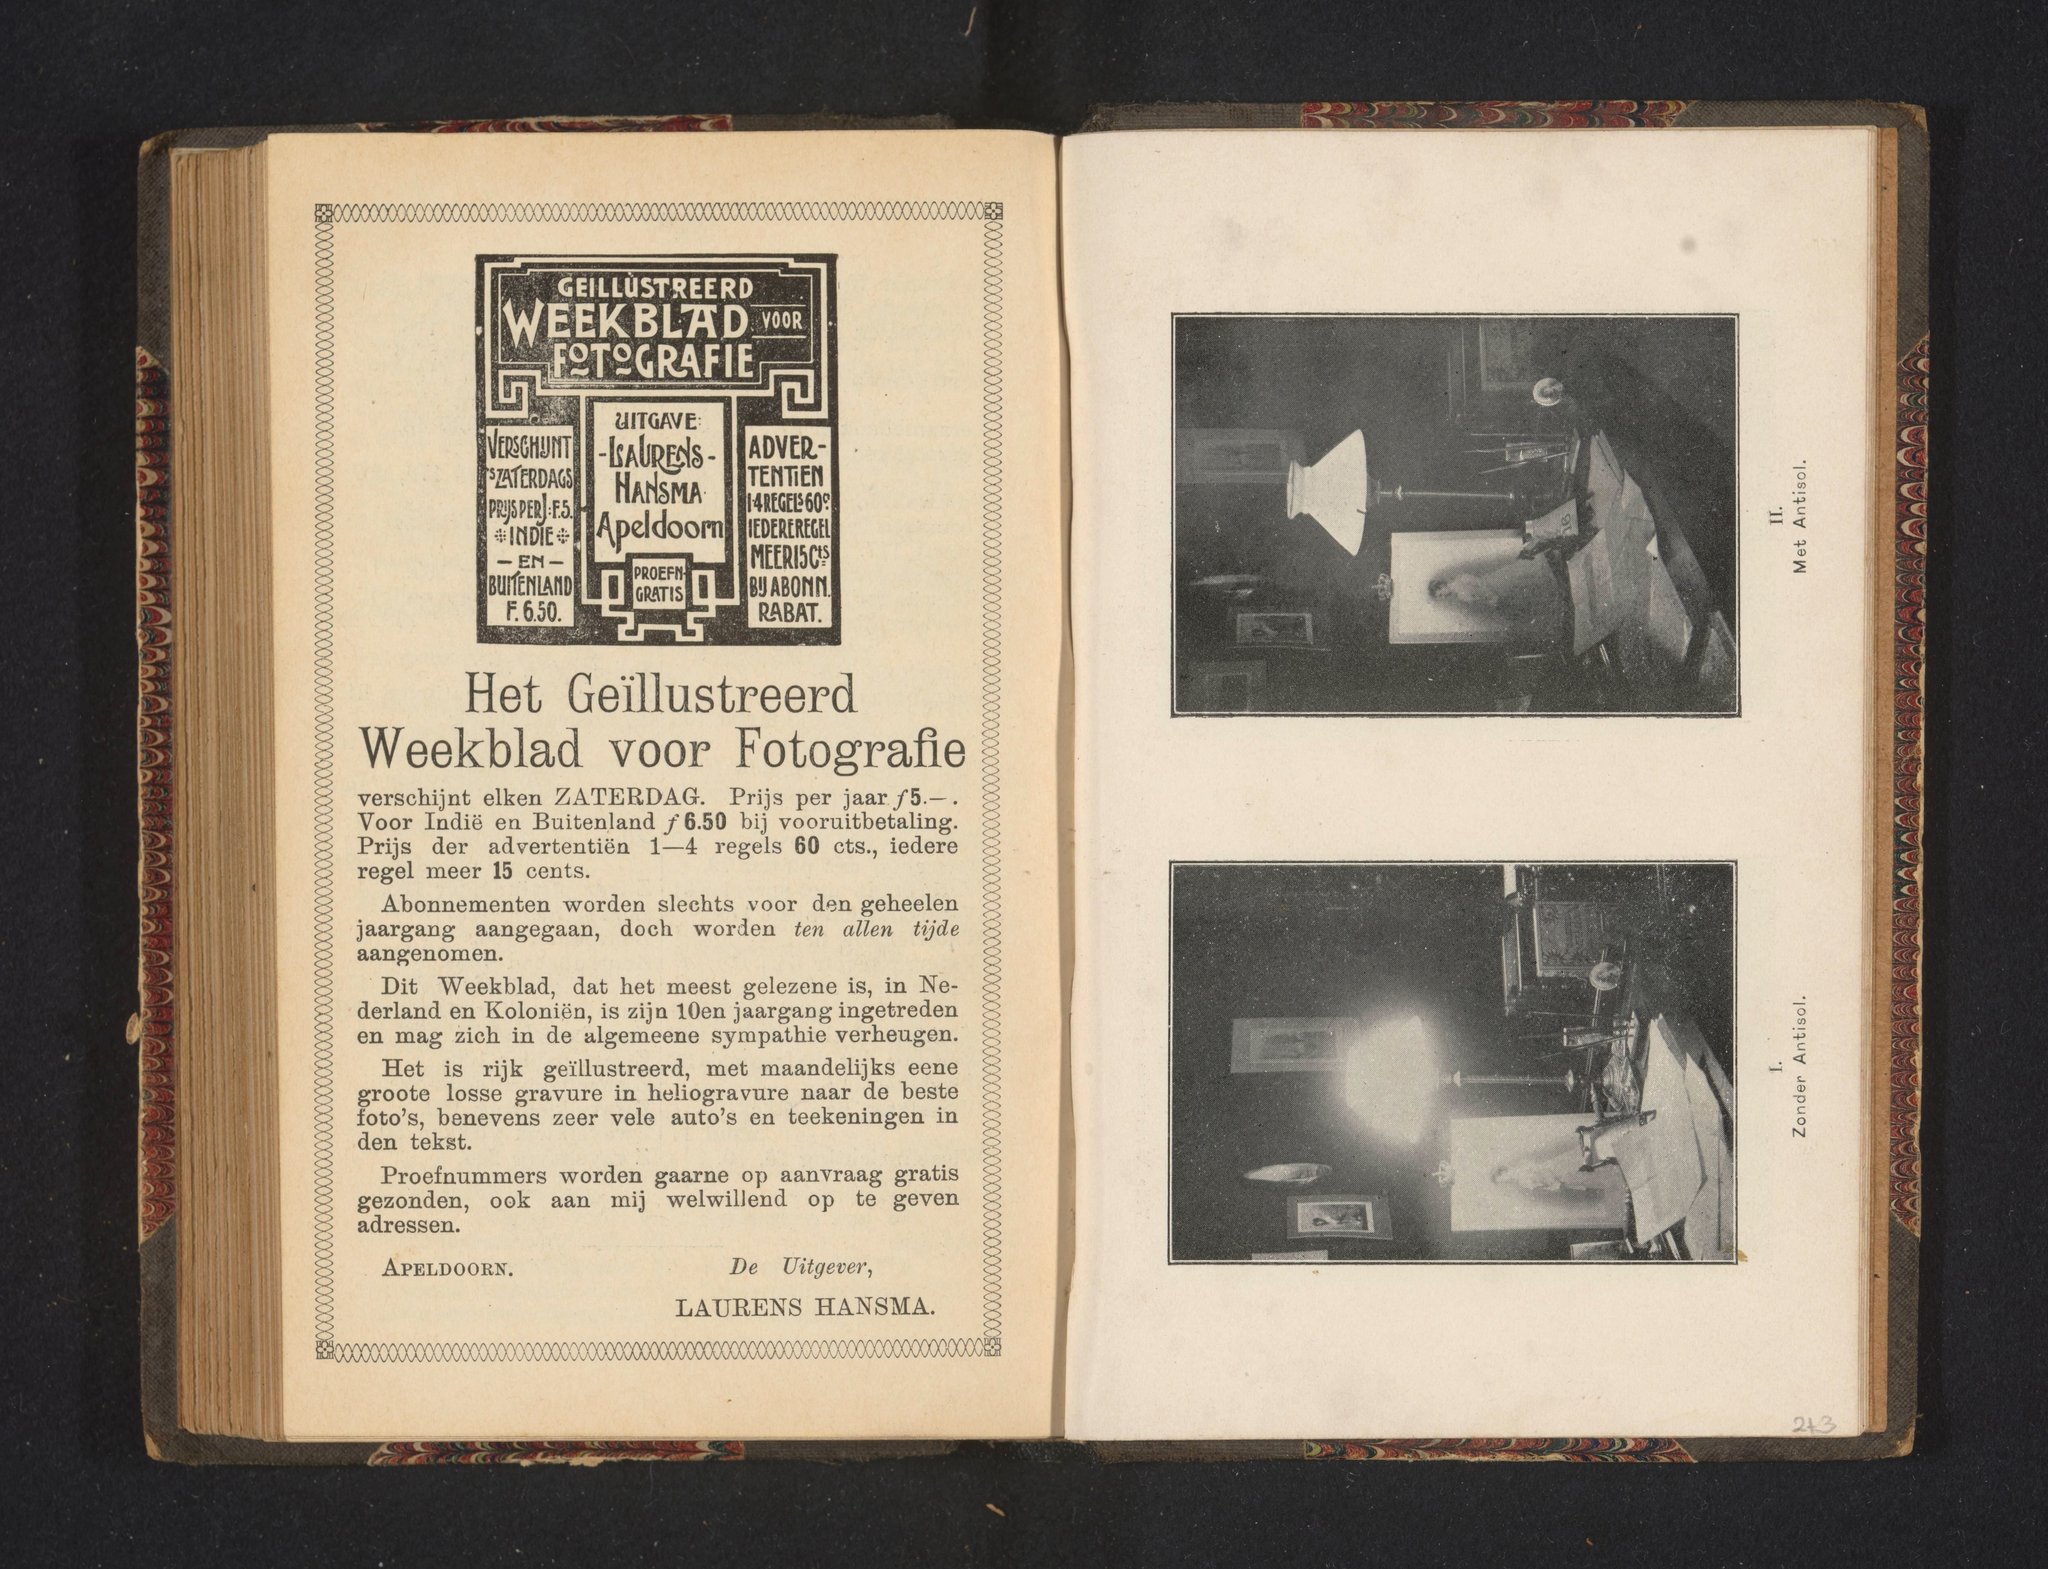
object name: photomechanical print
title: II./ Met Antisol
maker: Anonymous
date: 1897-1902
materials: paper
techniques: autotype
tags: writing-table, writing-desk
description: Prent twee van veertien prenten na pagina 241.